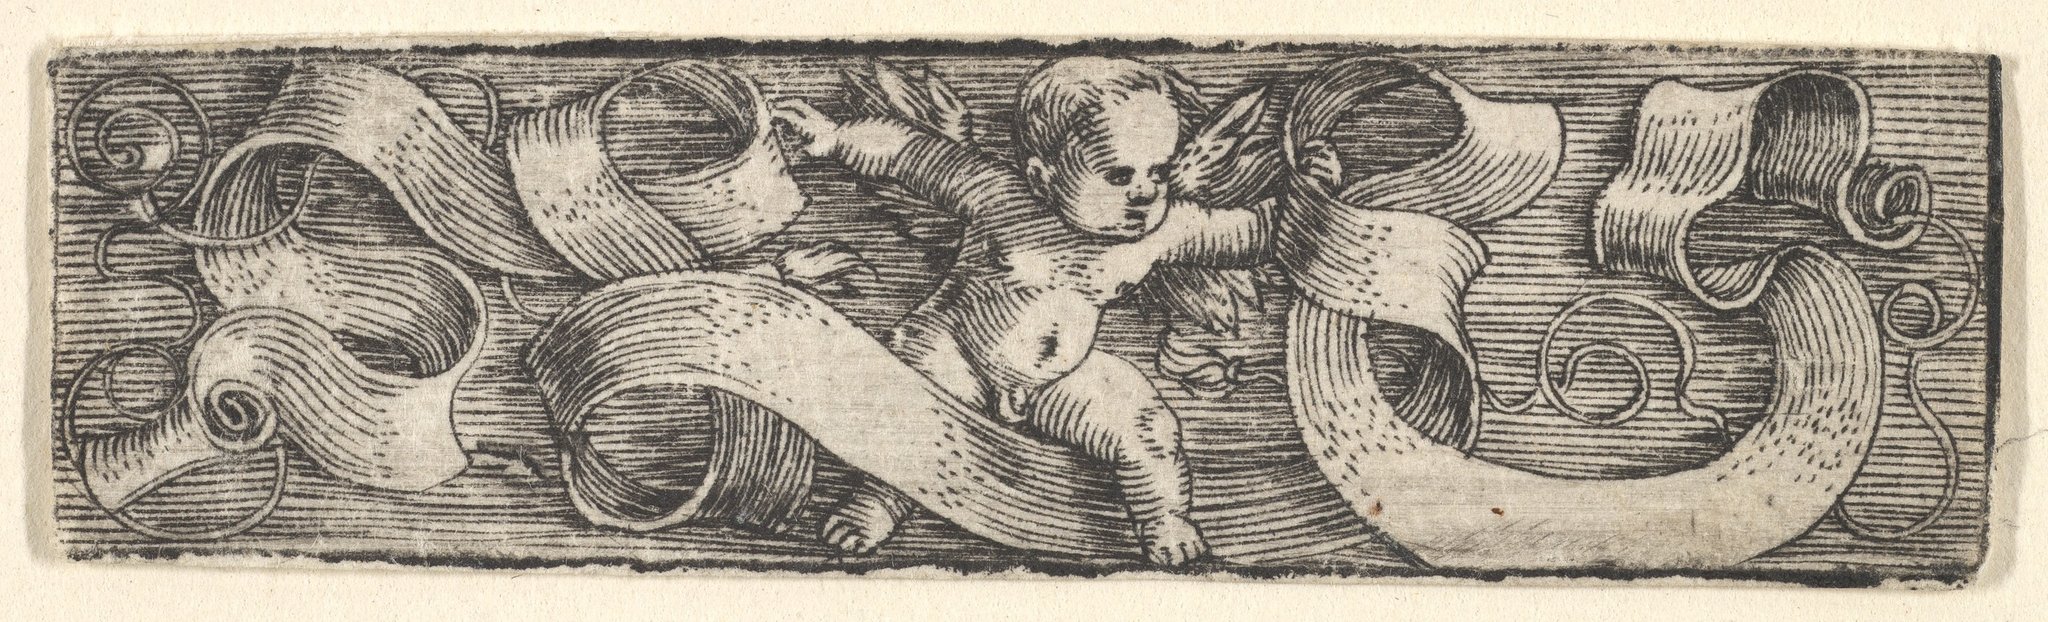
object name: print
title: Boy Stepping to the Right over Banderoles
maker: barthel beham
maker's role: artist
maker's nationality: german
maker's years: 1502-1540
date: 1634-1666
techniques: engraving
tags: boys,flags